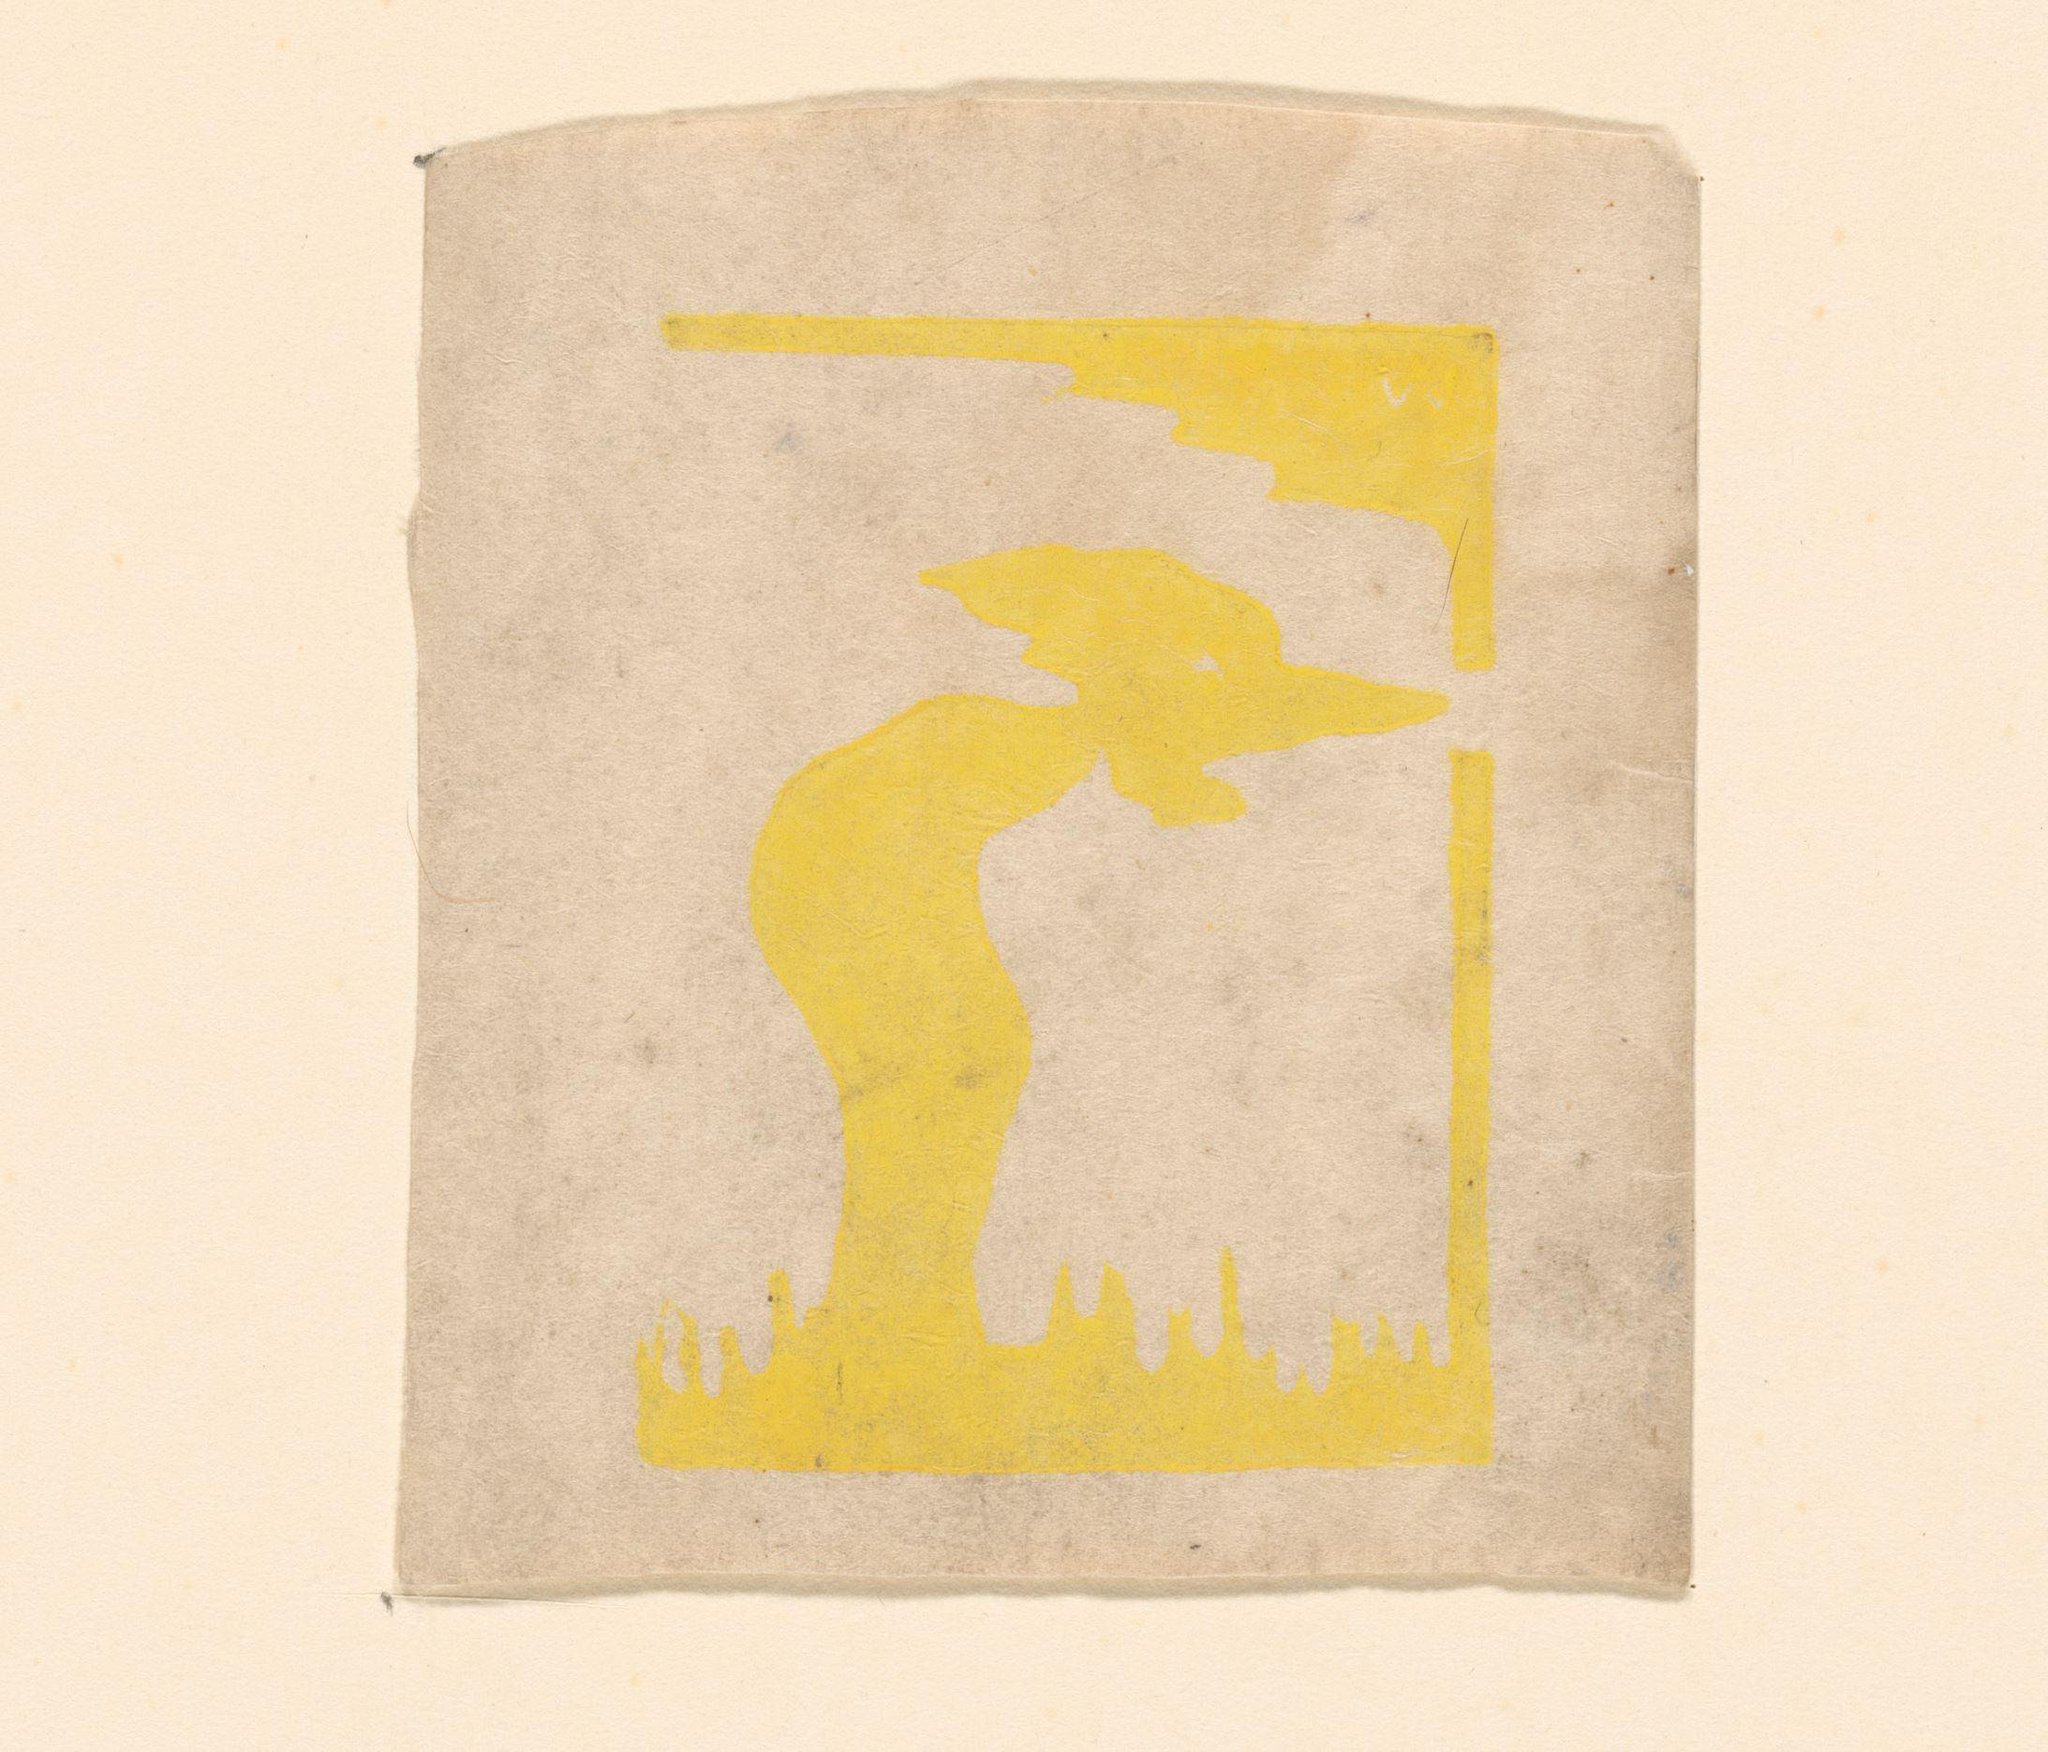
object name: print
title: Abstracte compositie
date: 1903-1920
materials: paper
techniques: mezzotint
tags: abstract, non-representational art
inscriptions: inscription: ‘Voor Jan Havermans’, collector's mark: Lugt 2228